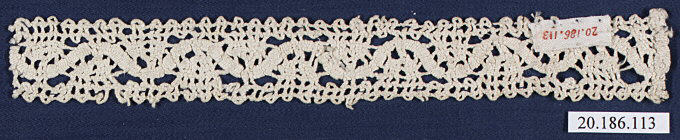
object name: insertion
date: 1501-1700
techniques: lace